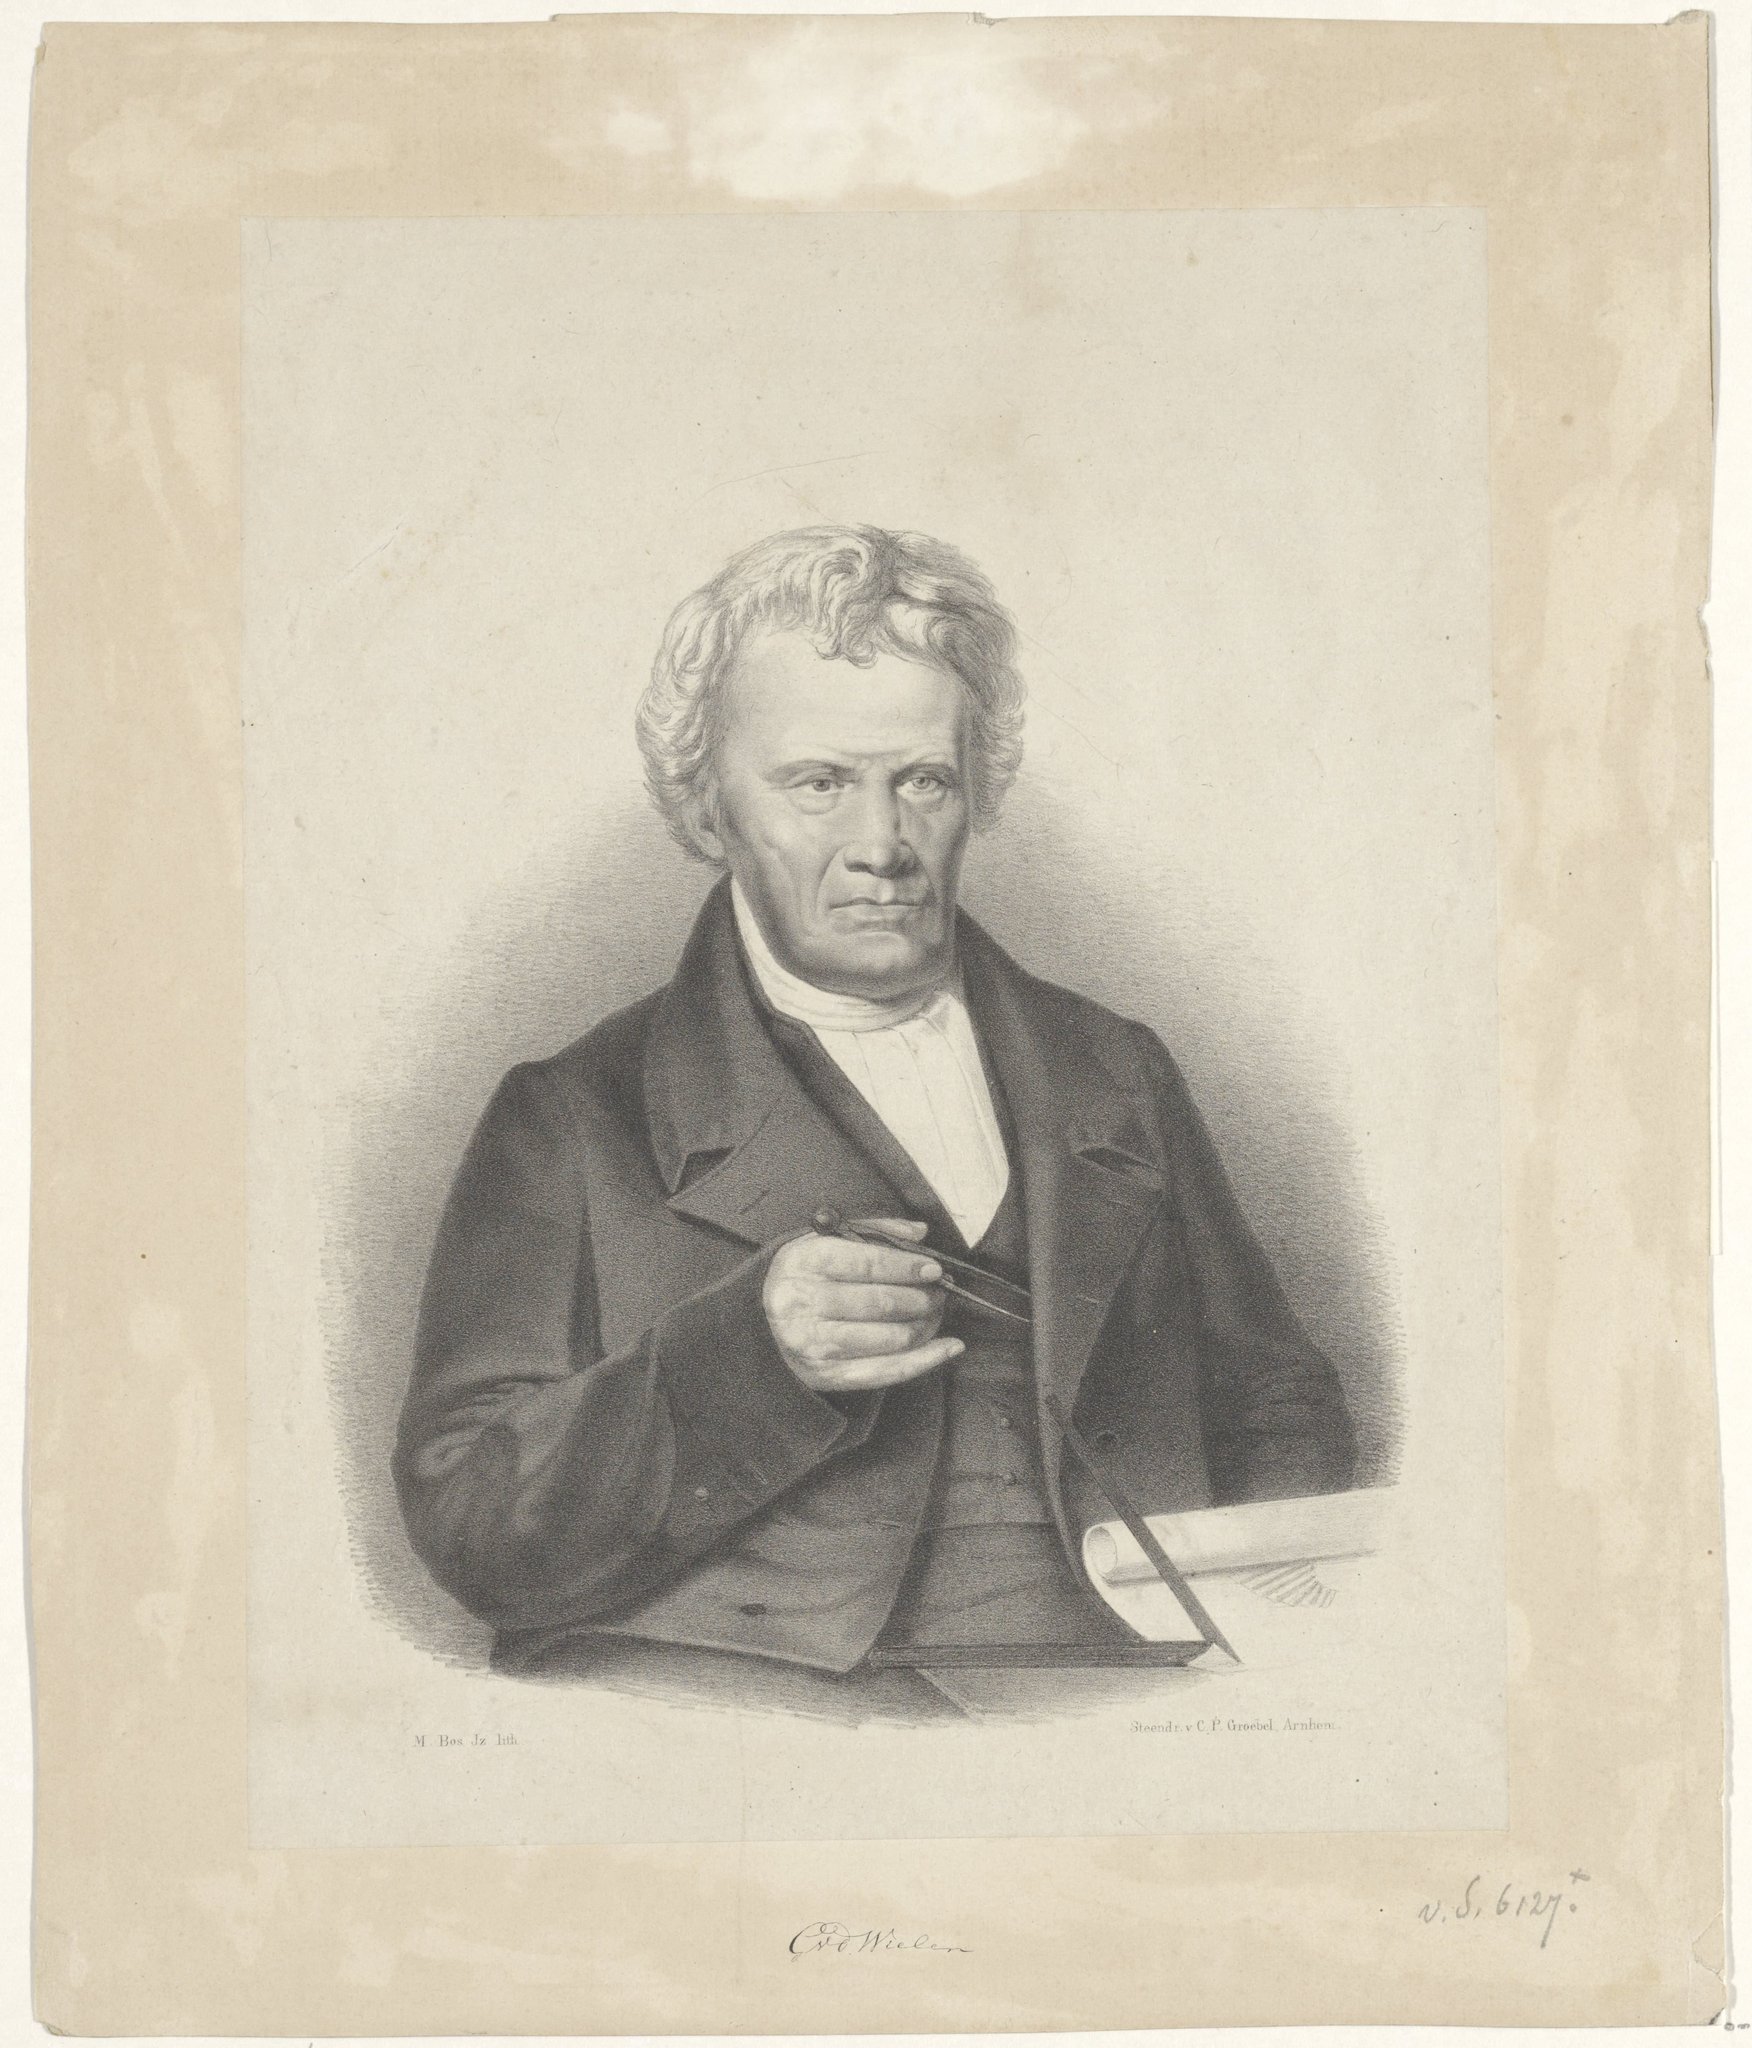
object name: print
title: Portret van Gerrit van der Wielen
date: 1861-1862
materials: paper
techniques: lithograph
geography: netherlands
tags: historical persons, compasses, portrait, self-portrait of architect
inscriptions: collector's mark: Lugt 2228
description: De geportretteerde heeft een passer in zijn rechterhand. Voor hem op tafel liggen een half opgerolde tekening en een winkelhaak. Onder het portret de signatuur van de geportretteerde.